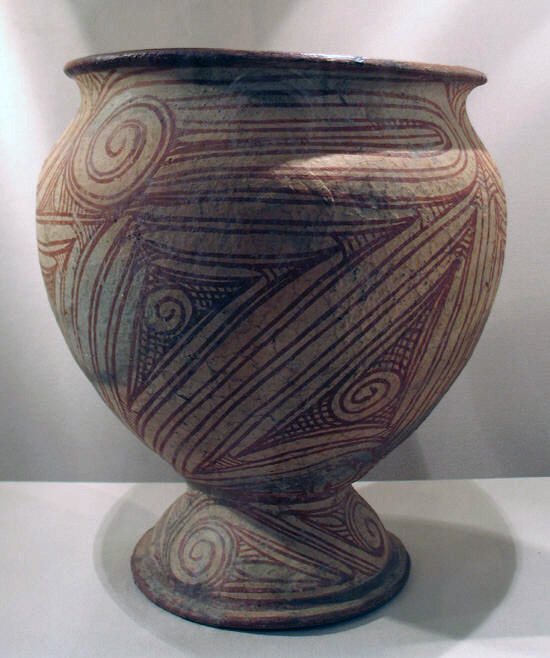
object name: vessel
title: Vessel with Pedestal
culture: thai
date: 300 BCE-200 CE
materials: earthenware